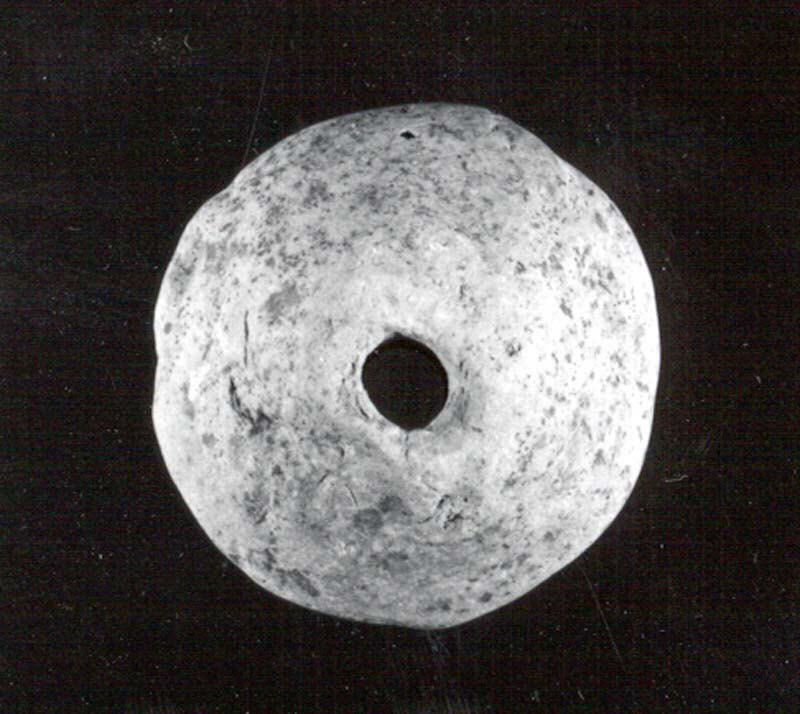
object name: whorl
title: Spindle whorl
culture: iranian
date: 5000-2001 BCE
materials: ceramic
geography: iran